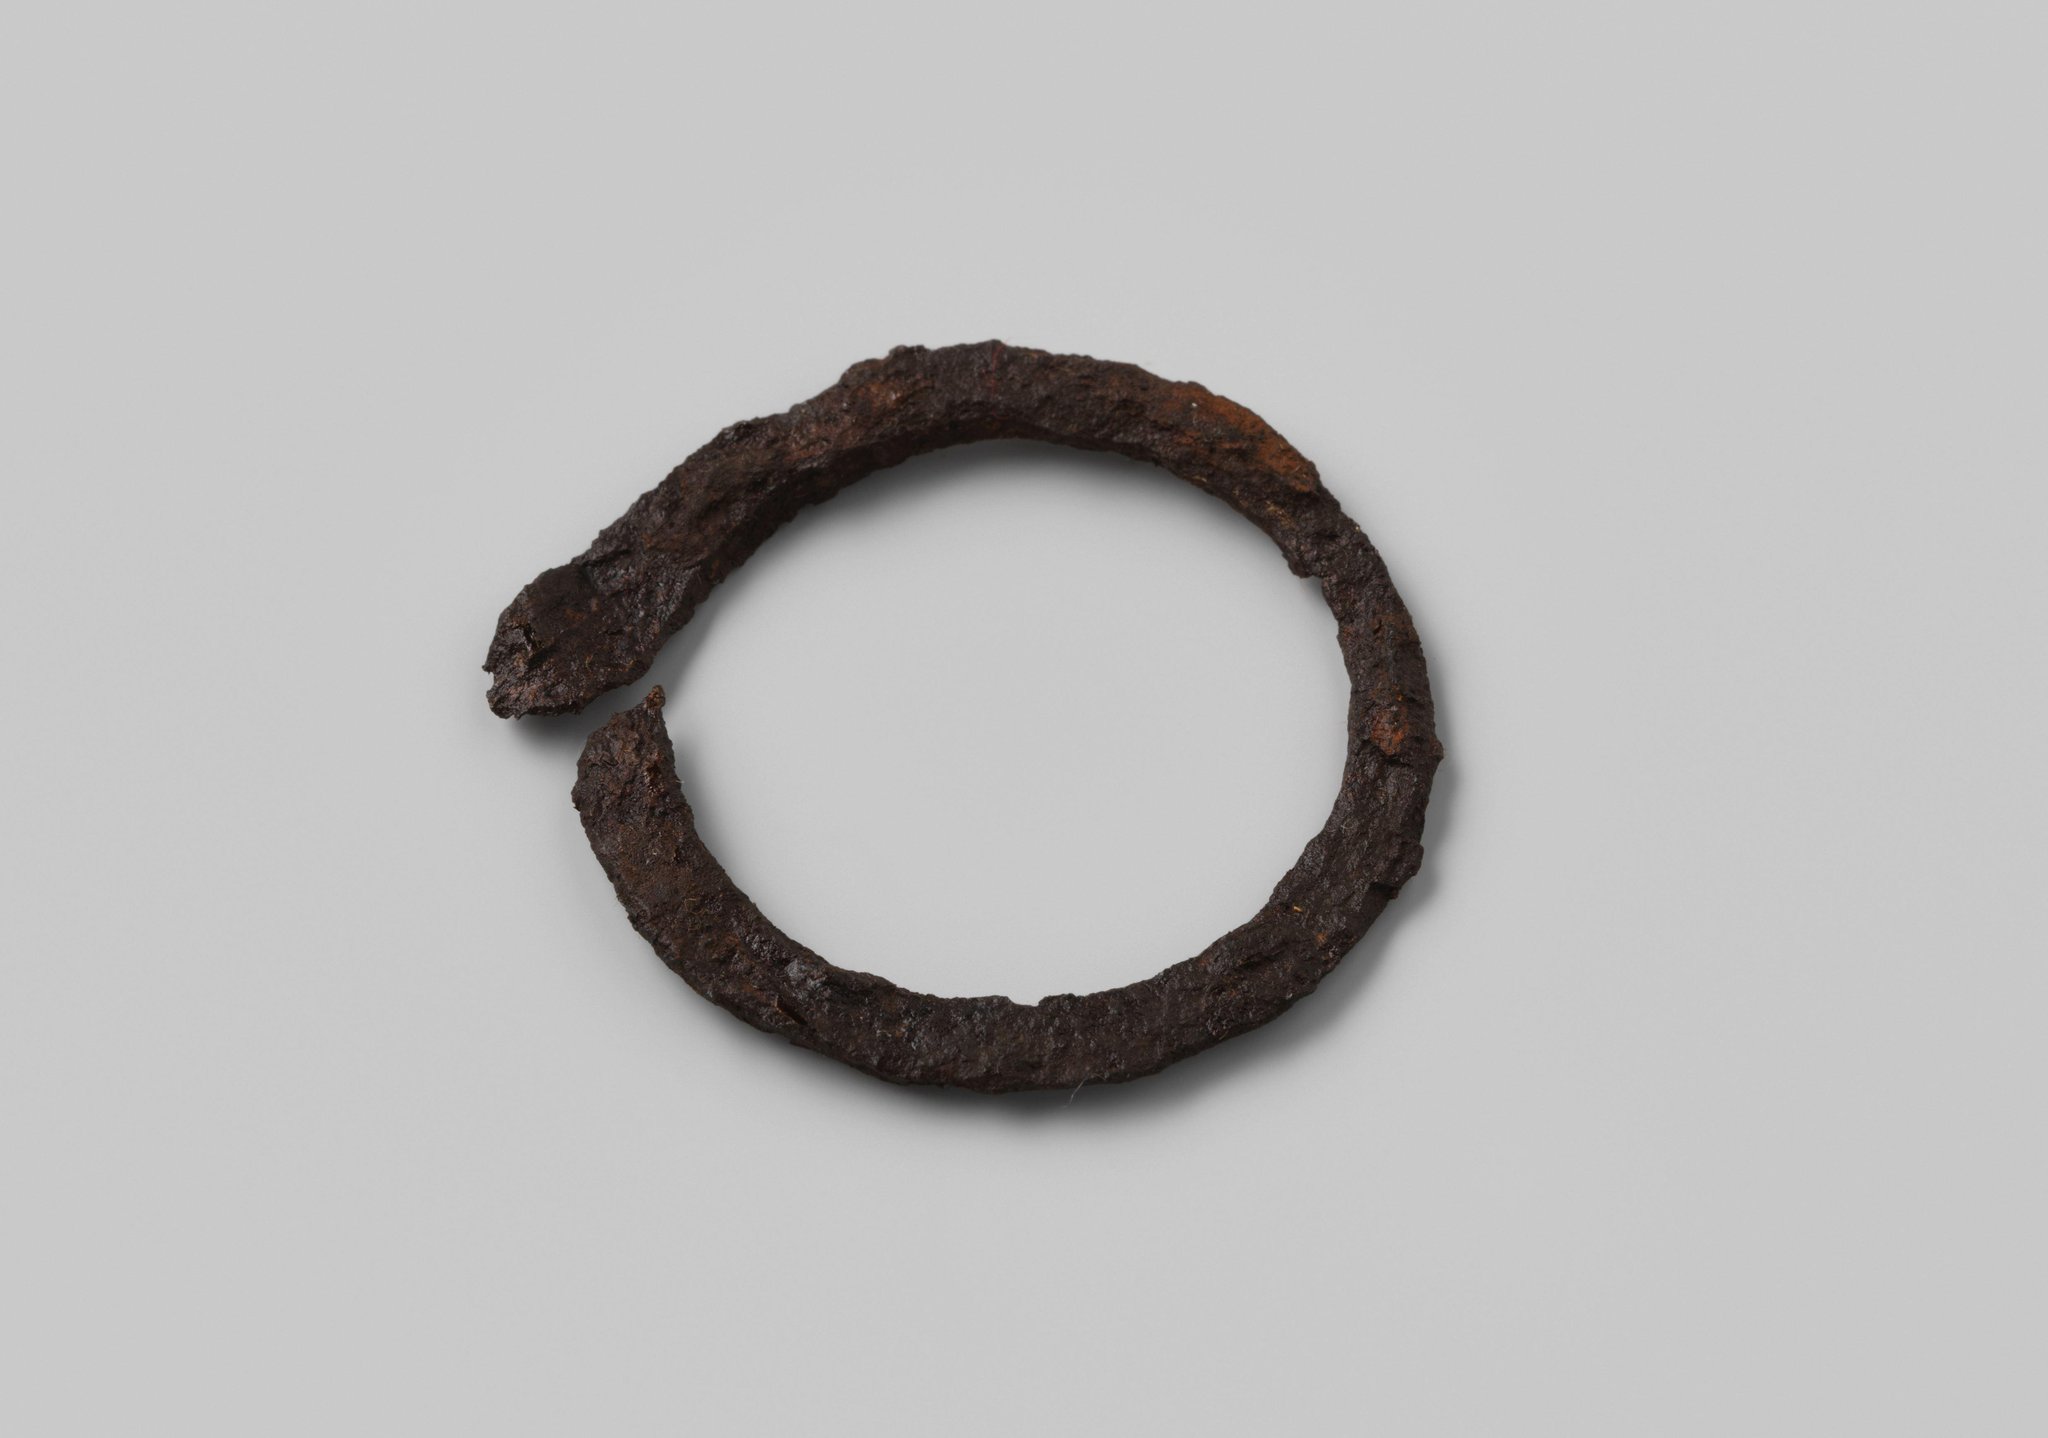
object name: ring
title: Ringvormig fragment uit het wrak van de Oost-Indiëvaarder Hollandia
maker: Anonymous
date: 1700-1743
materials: iron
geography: netherlands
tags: verenigde oostindische compagnie, hollandia (schip), annet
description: Varied parts or fragments, rings and ring-shaped fragments; id. 80H1671, eroded.